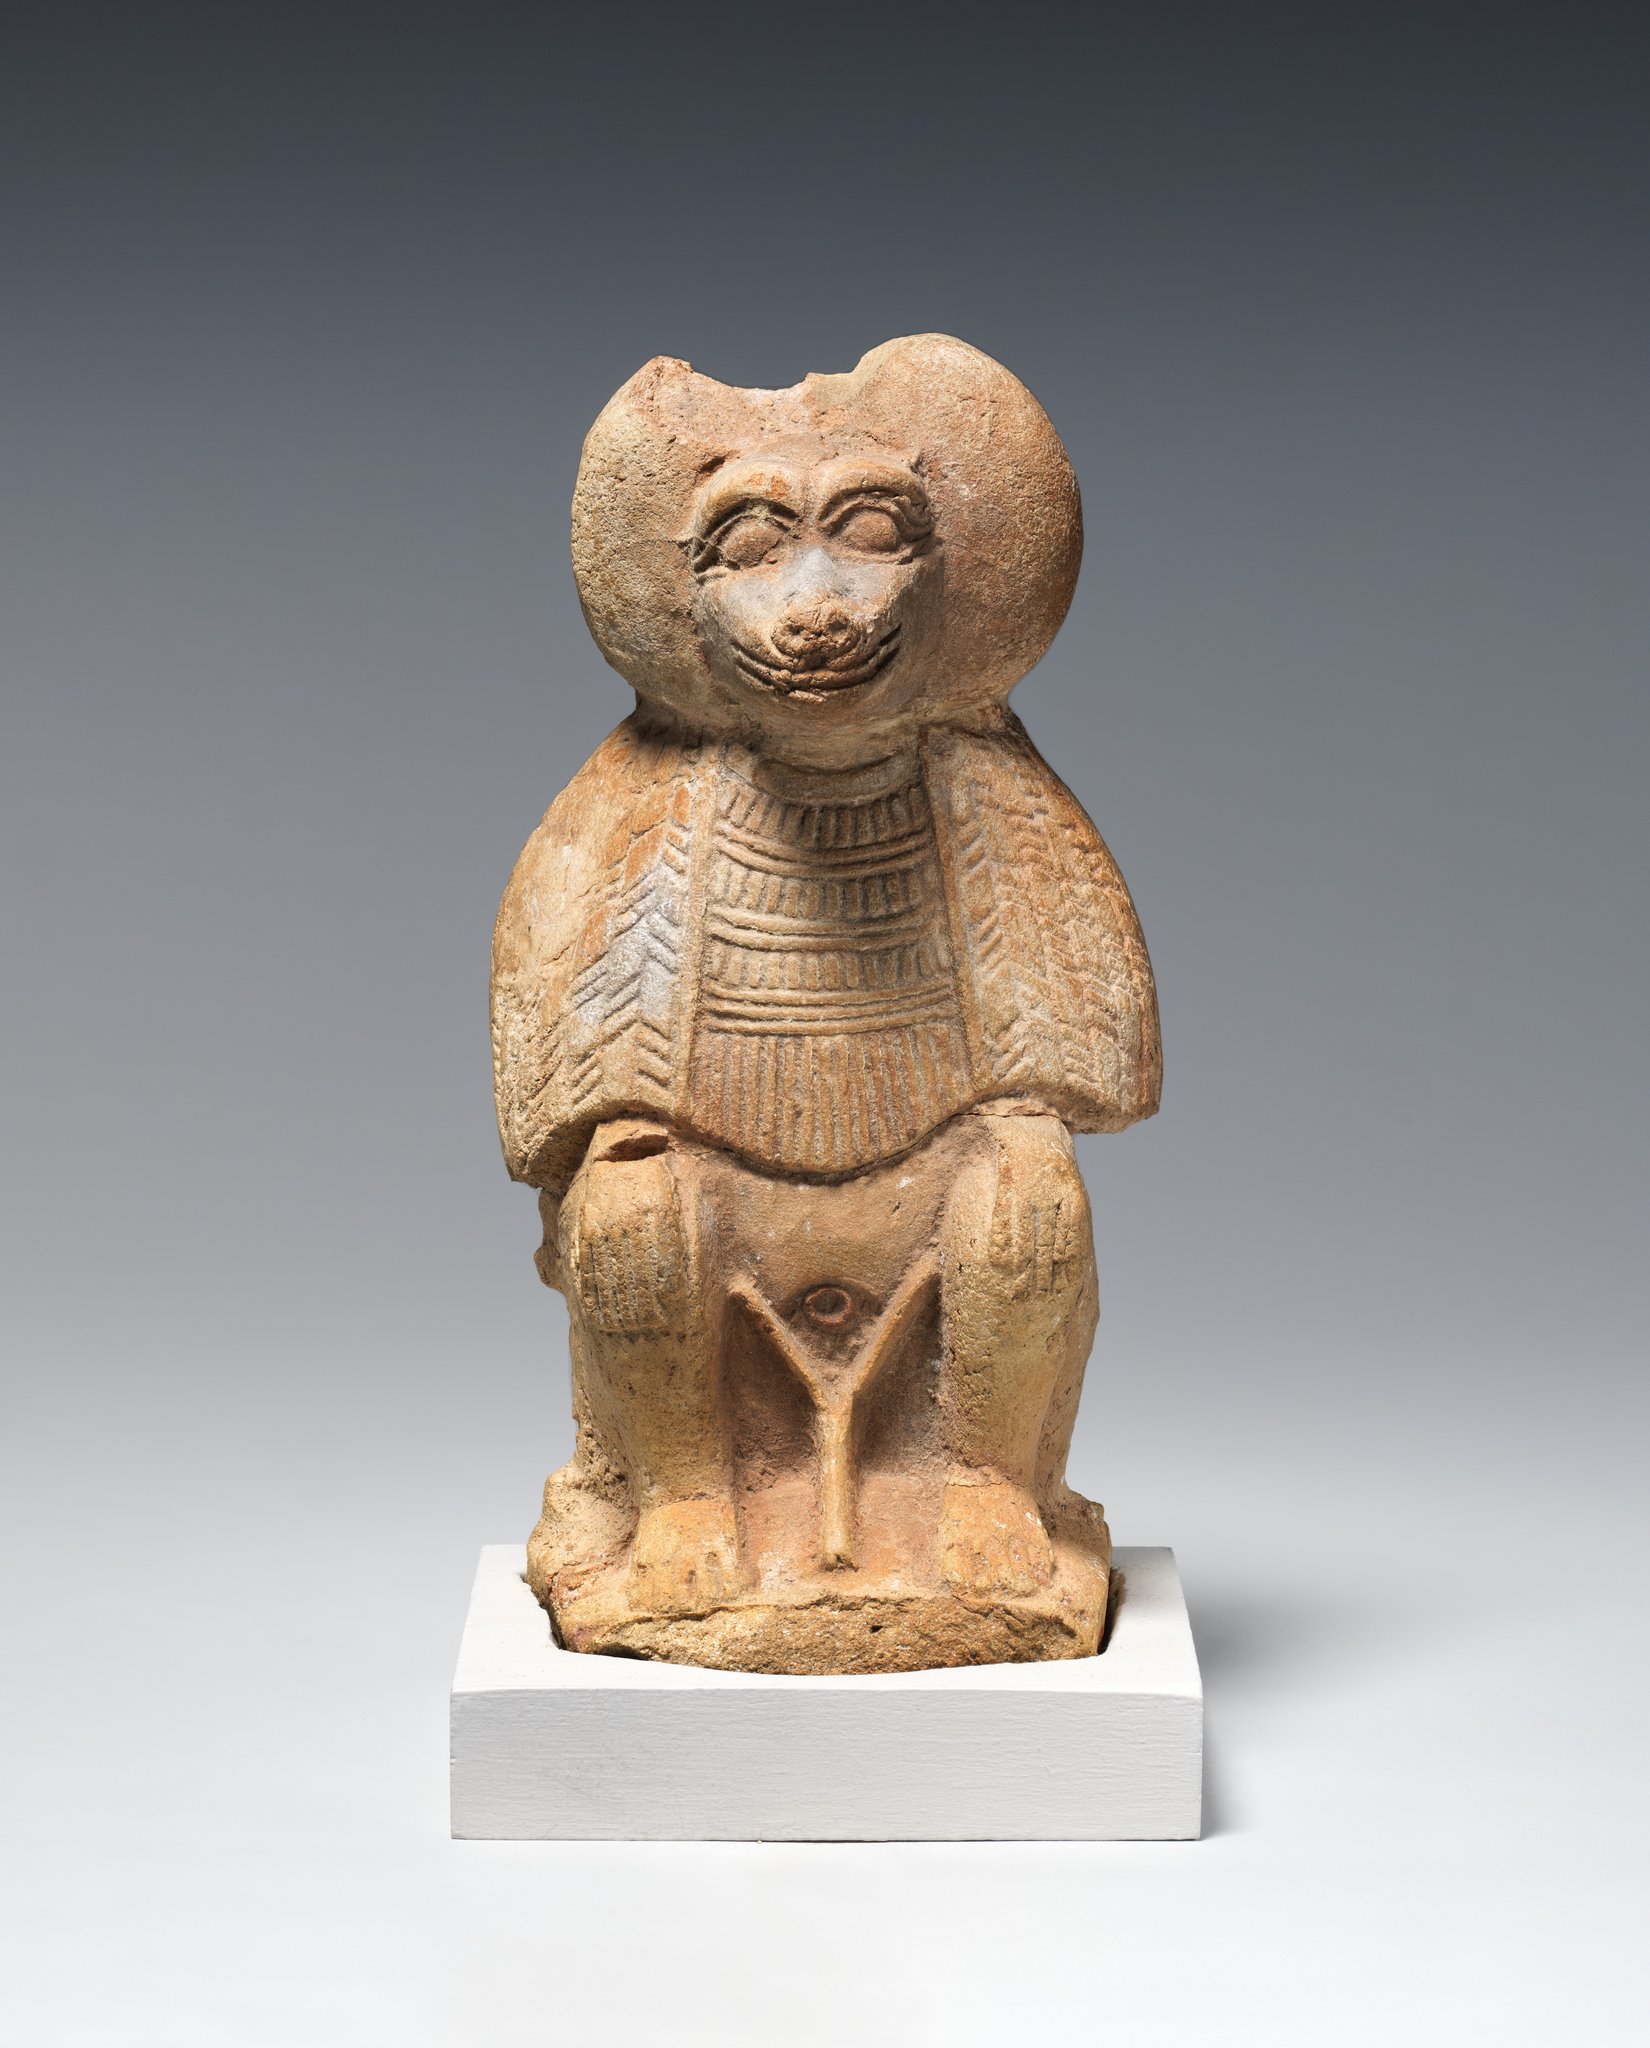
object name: figurine, baboon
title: Figure of a Cynocephalus Baboon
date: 664-332 BCE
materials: pottery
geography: egypt